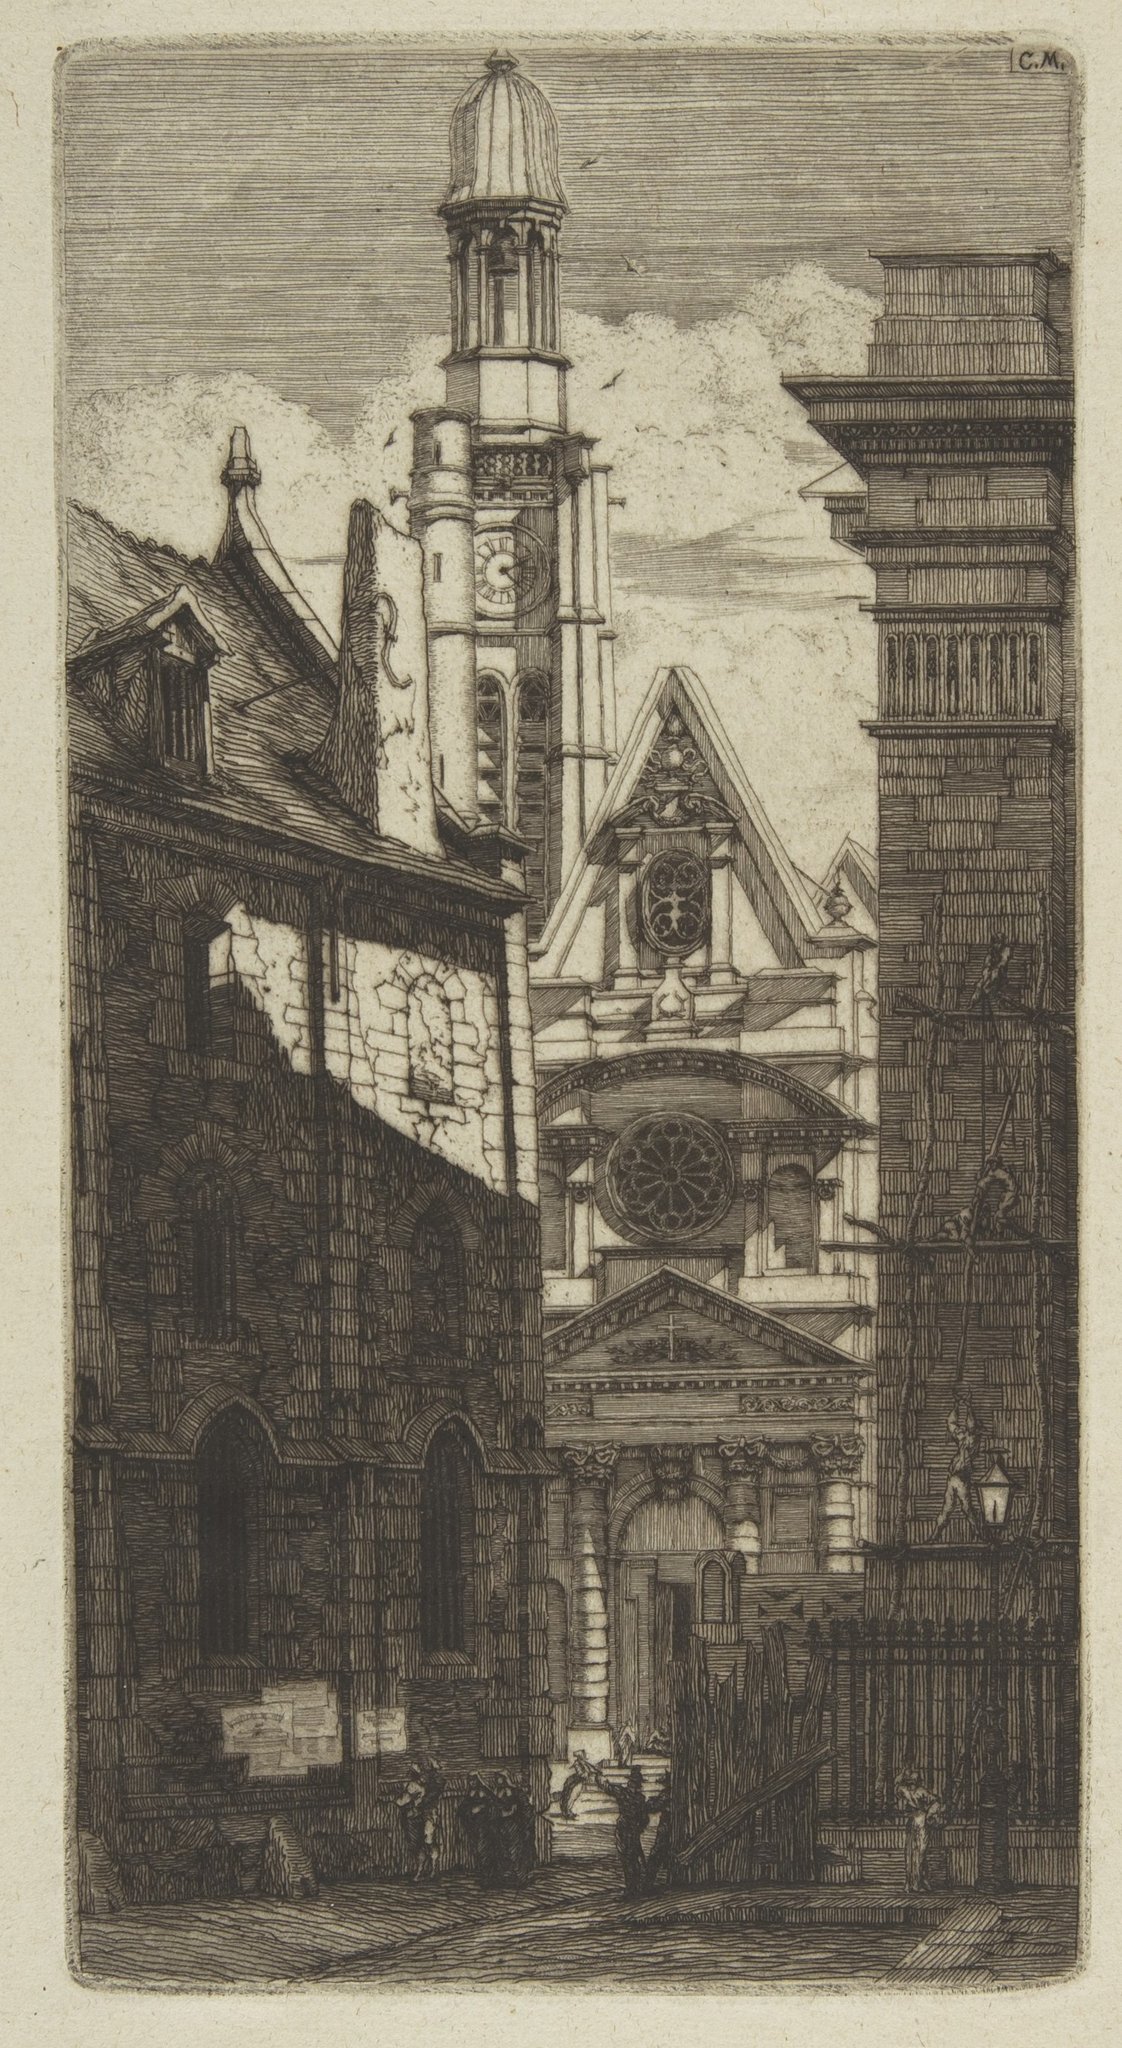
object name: print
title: The Church of St. Etienne-du-Mont, Paris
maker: charles meryon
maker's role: artist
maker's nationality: french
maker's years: 1821-1868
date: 1852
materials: paper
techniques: drypoint, etching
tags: churches,paris